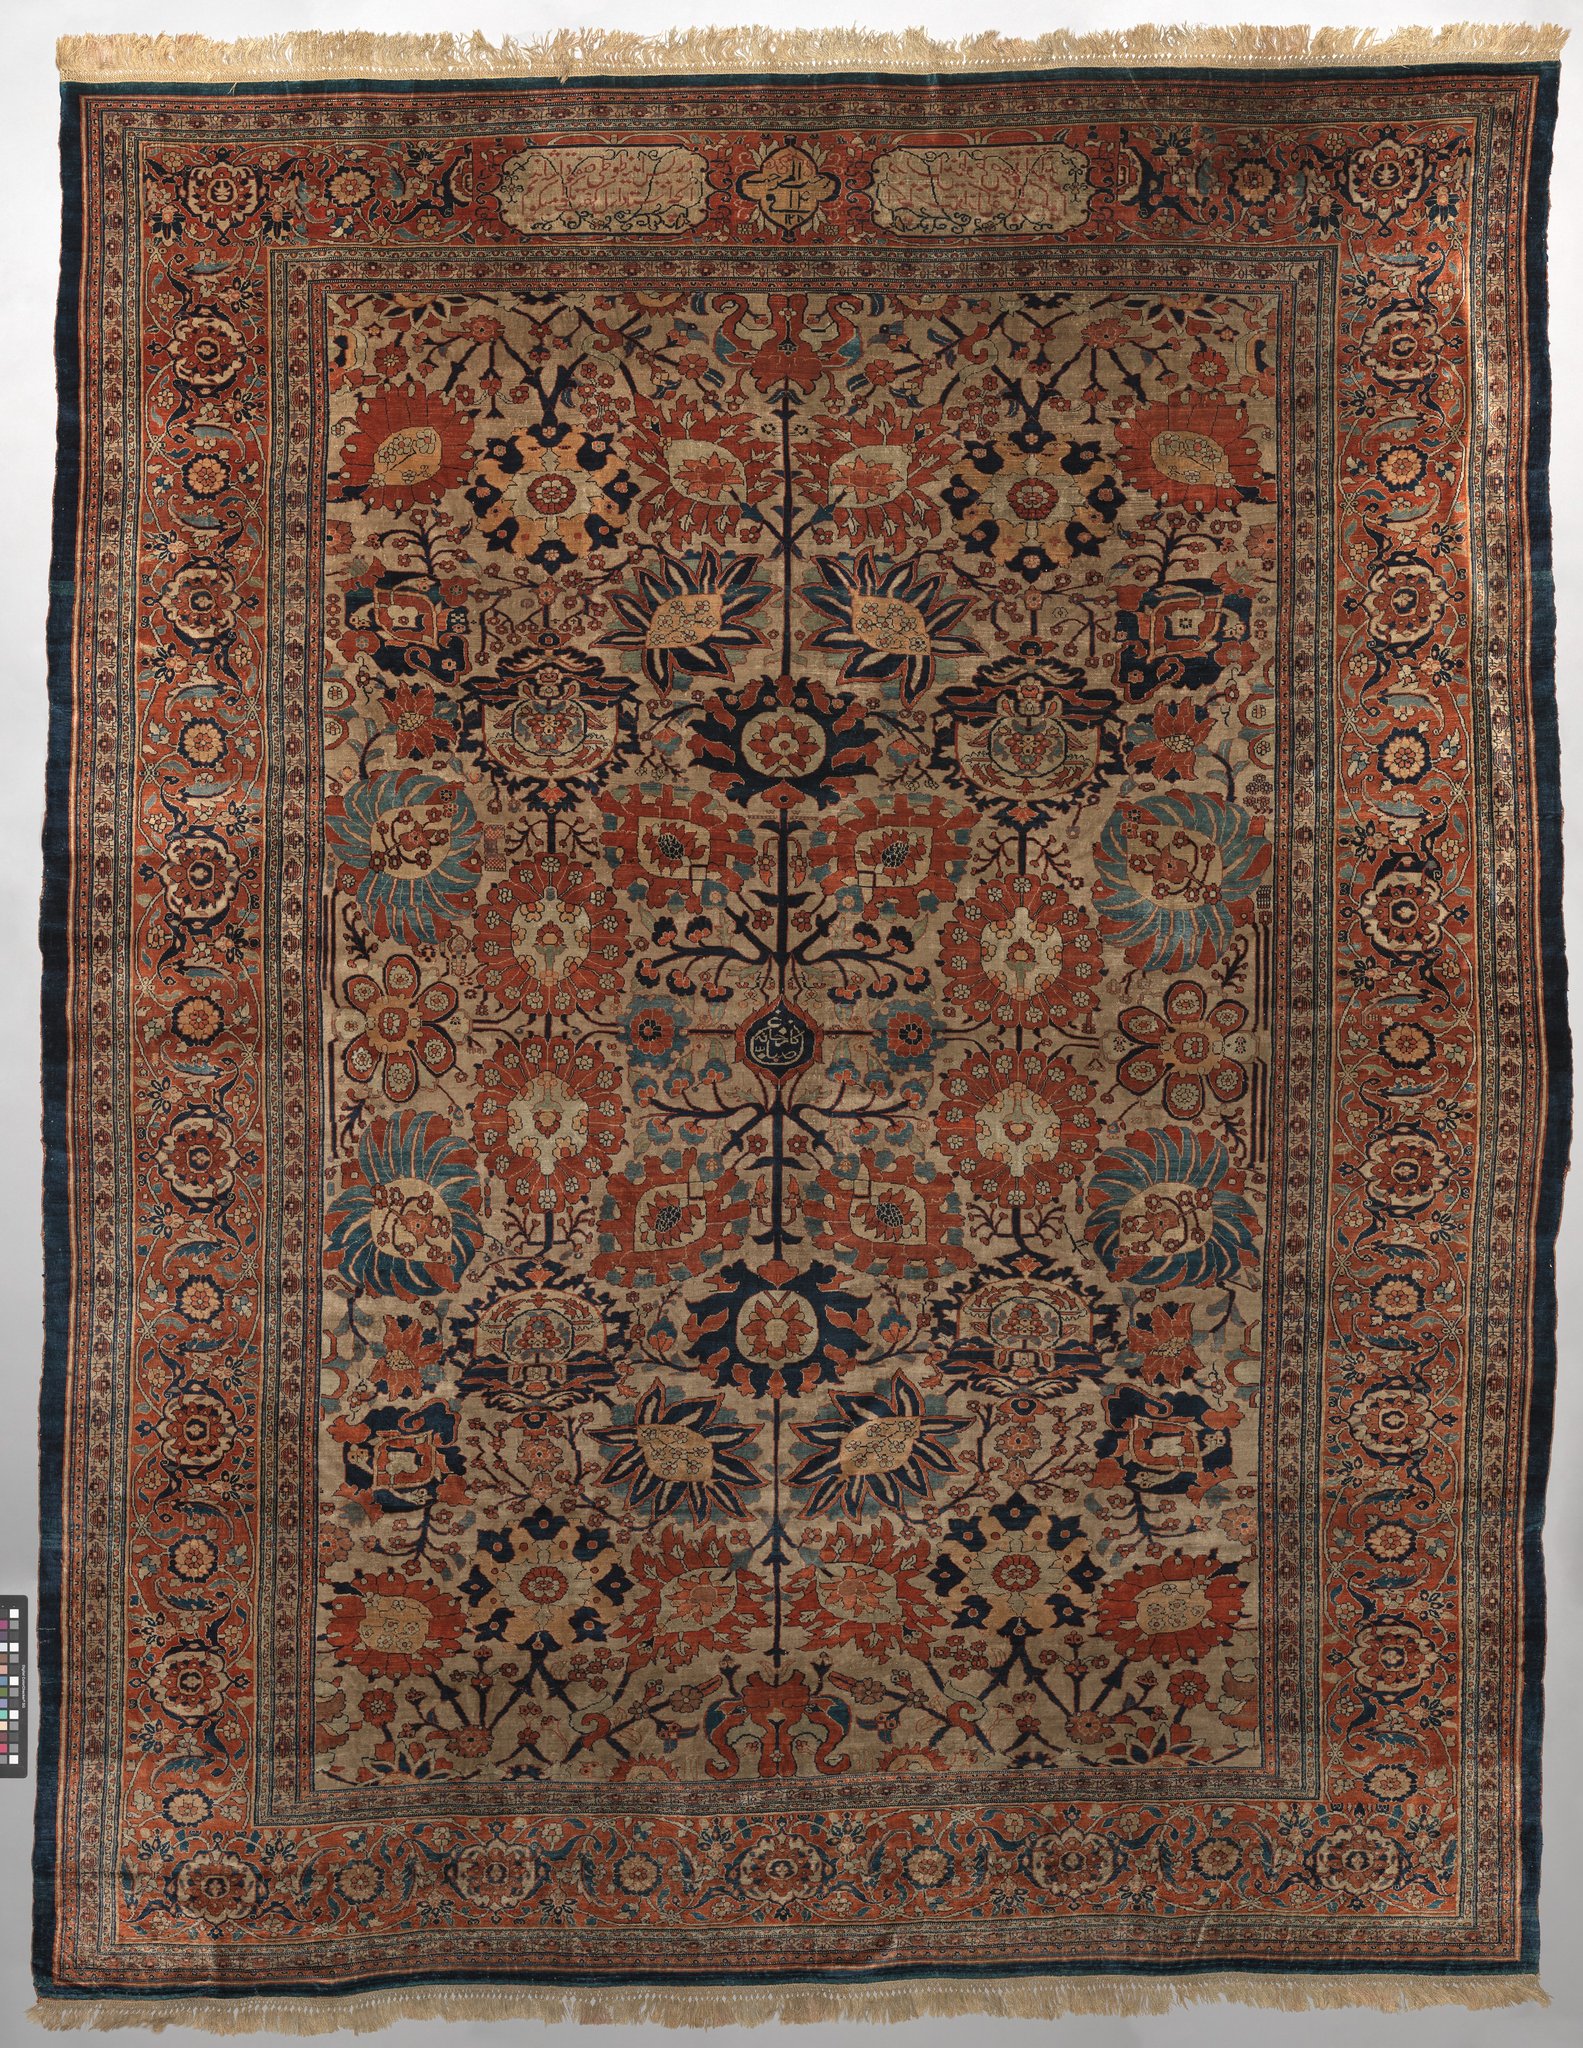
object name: carpet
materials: silk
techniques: pile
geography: iran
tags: flowers